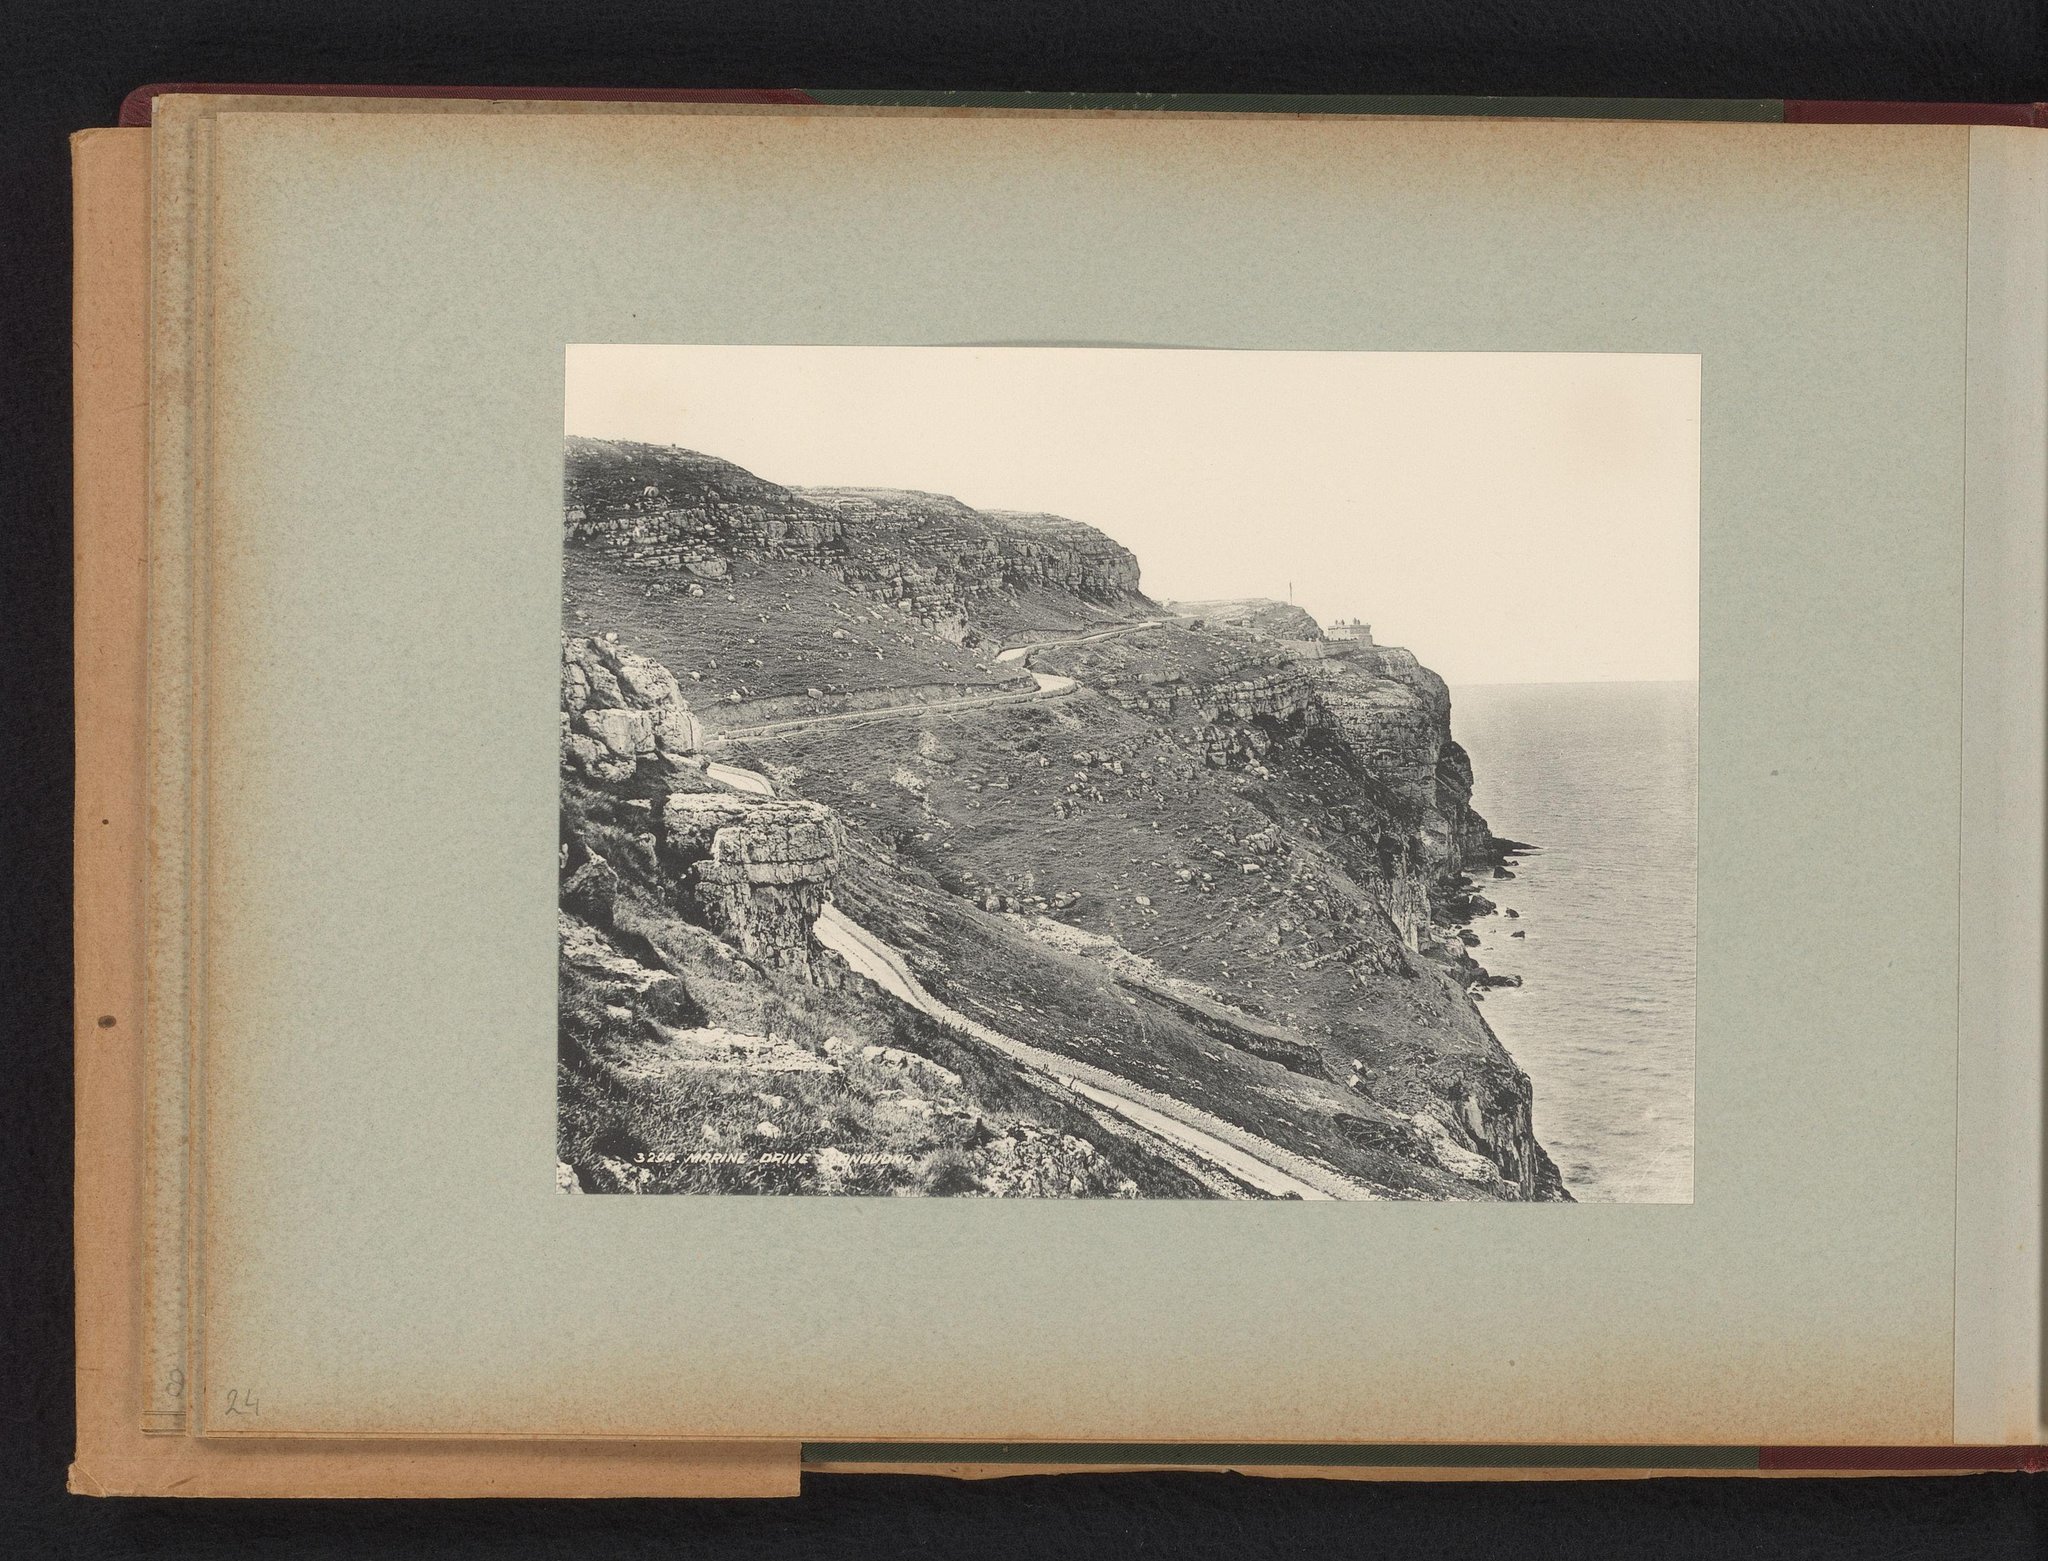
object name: album leaf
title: Marine Drive nabij Llandudno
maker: Anonymous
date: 1880-1900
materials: paper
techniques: photograph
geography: llandudno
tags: coastal cliff or crag, public road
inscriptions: number: ‘3294.’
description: Deze prent maakt deel uit van een album.